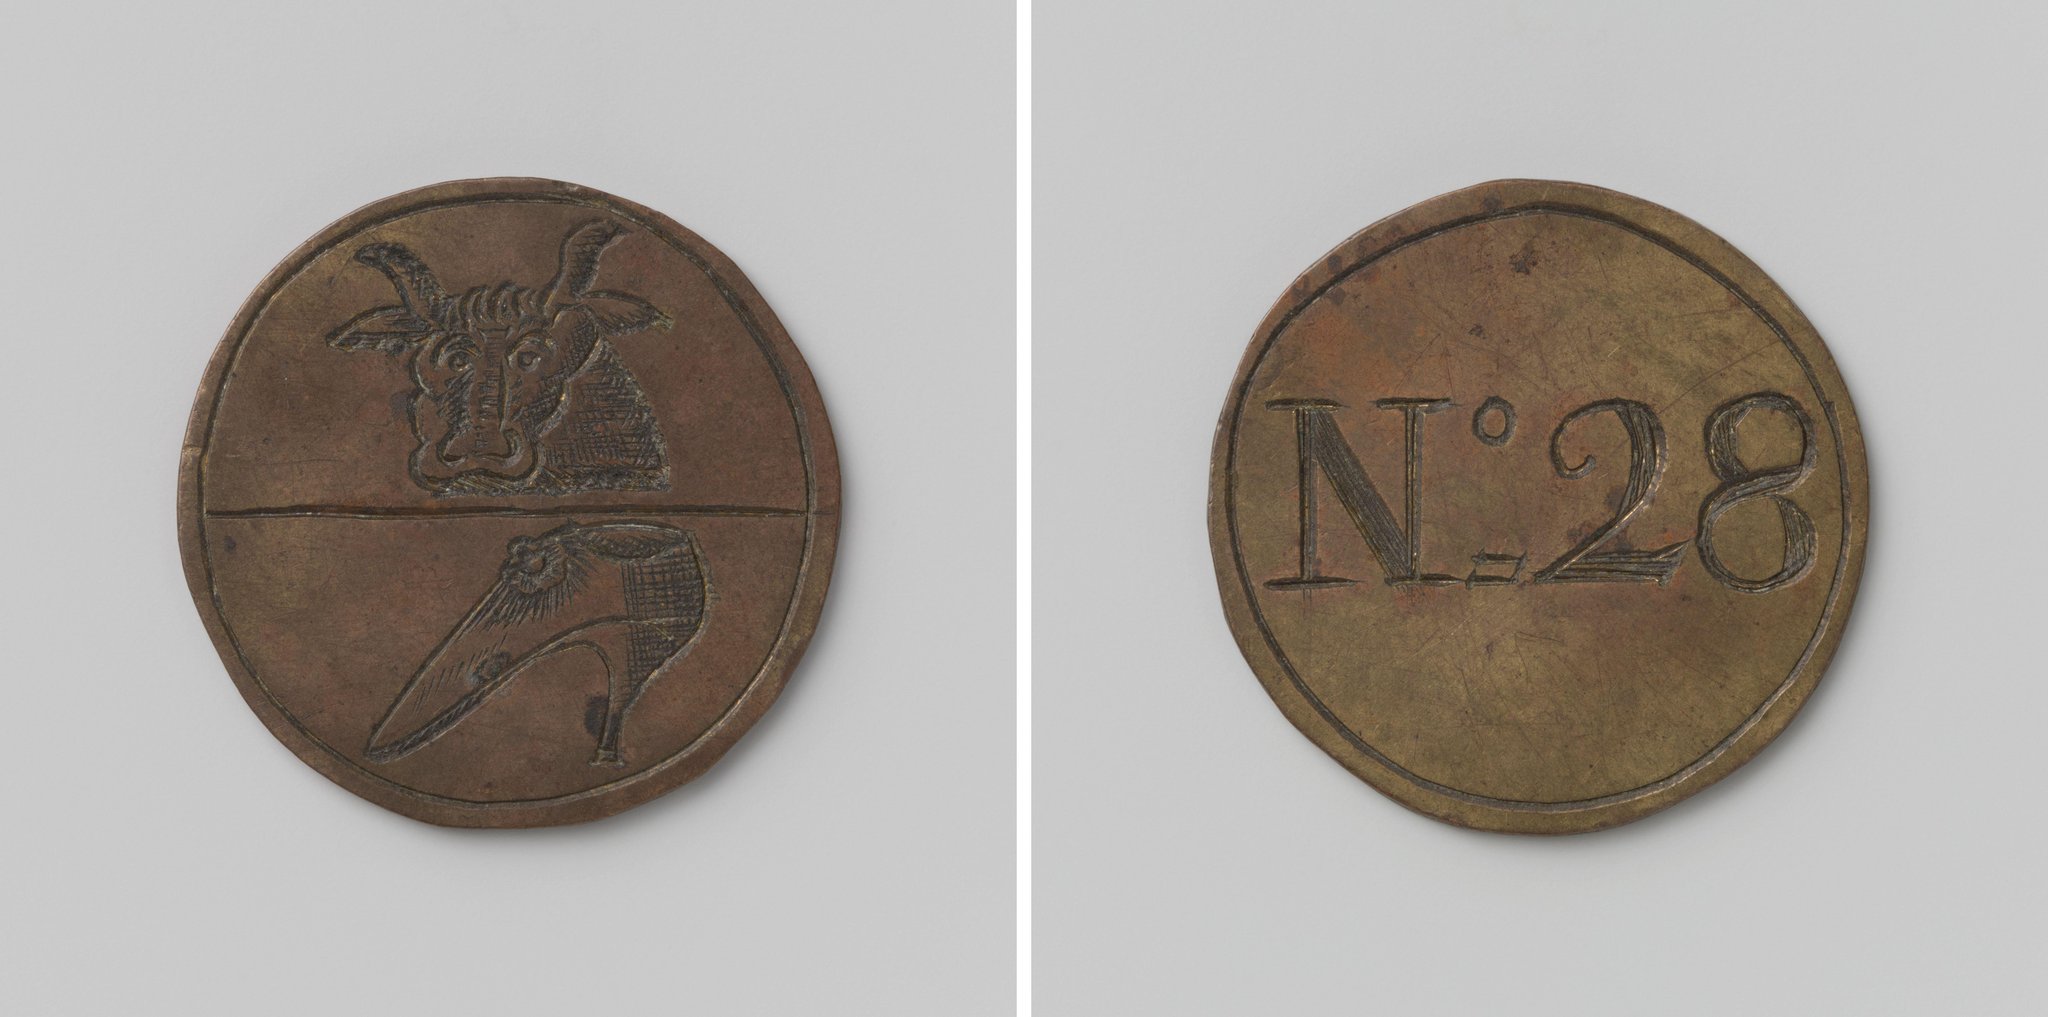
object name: medal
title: Huidenkopers-, looiers- en schoenmakersgilde van Amsterdam, gildepenning met no. 28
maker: Anonymous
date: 1664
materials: brass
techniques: engraving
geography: amsterdam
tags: amsterdam